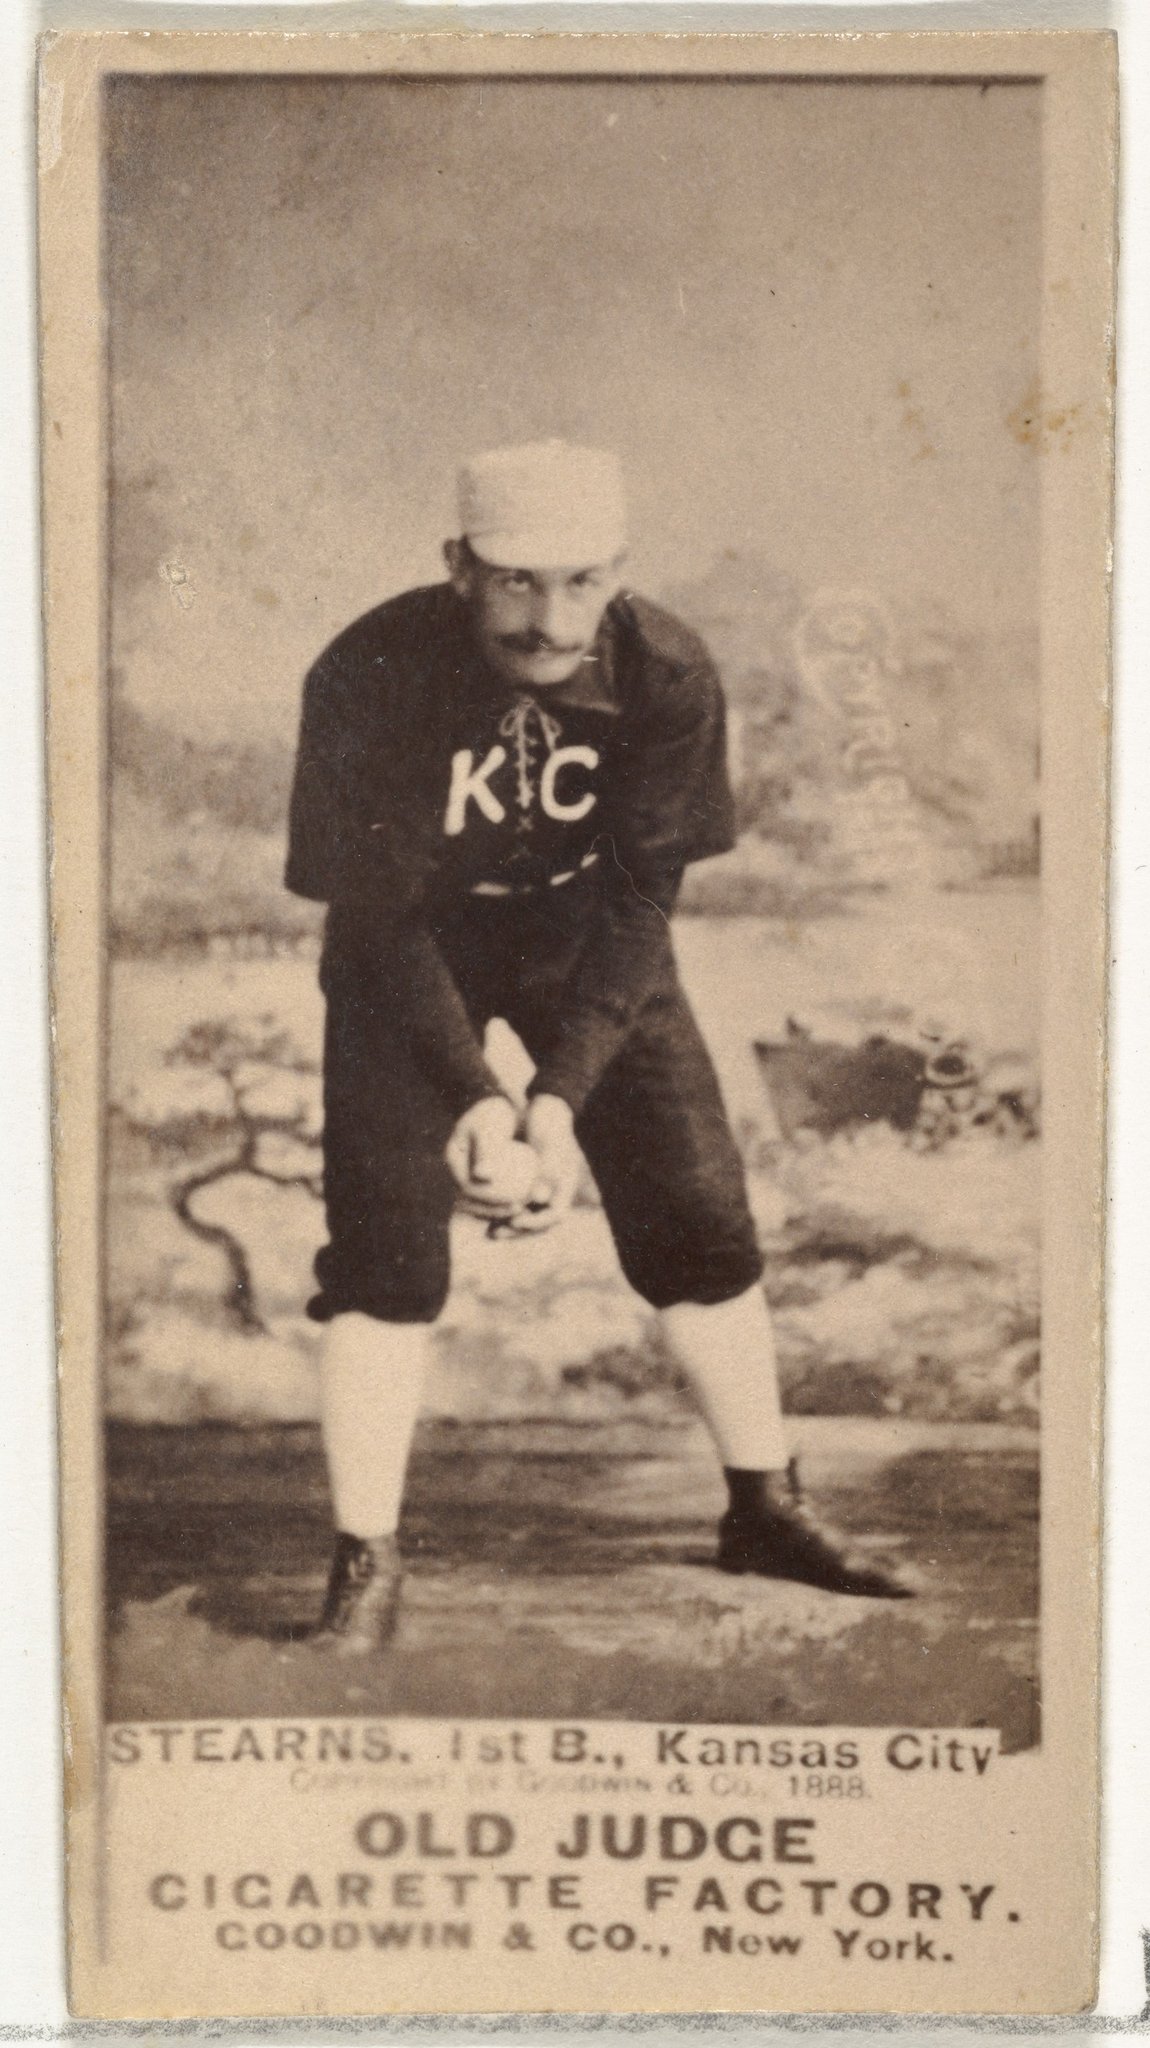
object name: baseball card, photograph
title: Daniel Eckford "Ecky" Stearns, 1st Base, Kansas City Cowboys, from the Old Judge series (N172) for Old Judge Cigarettes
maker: goodwin & company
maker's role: publisher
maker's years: 1850-1950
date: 1888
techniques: albumen silver print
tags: men,portraits,baseball,athletes